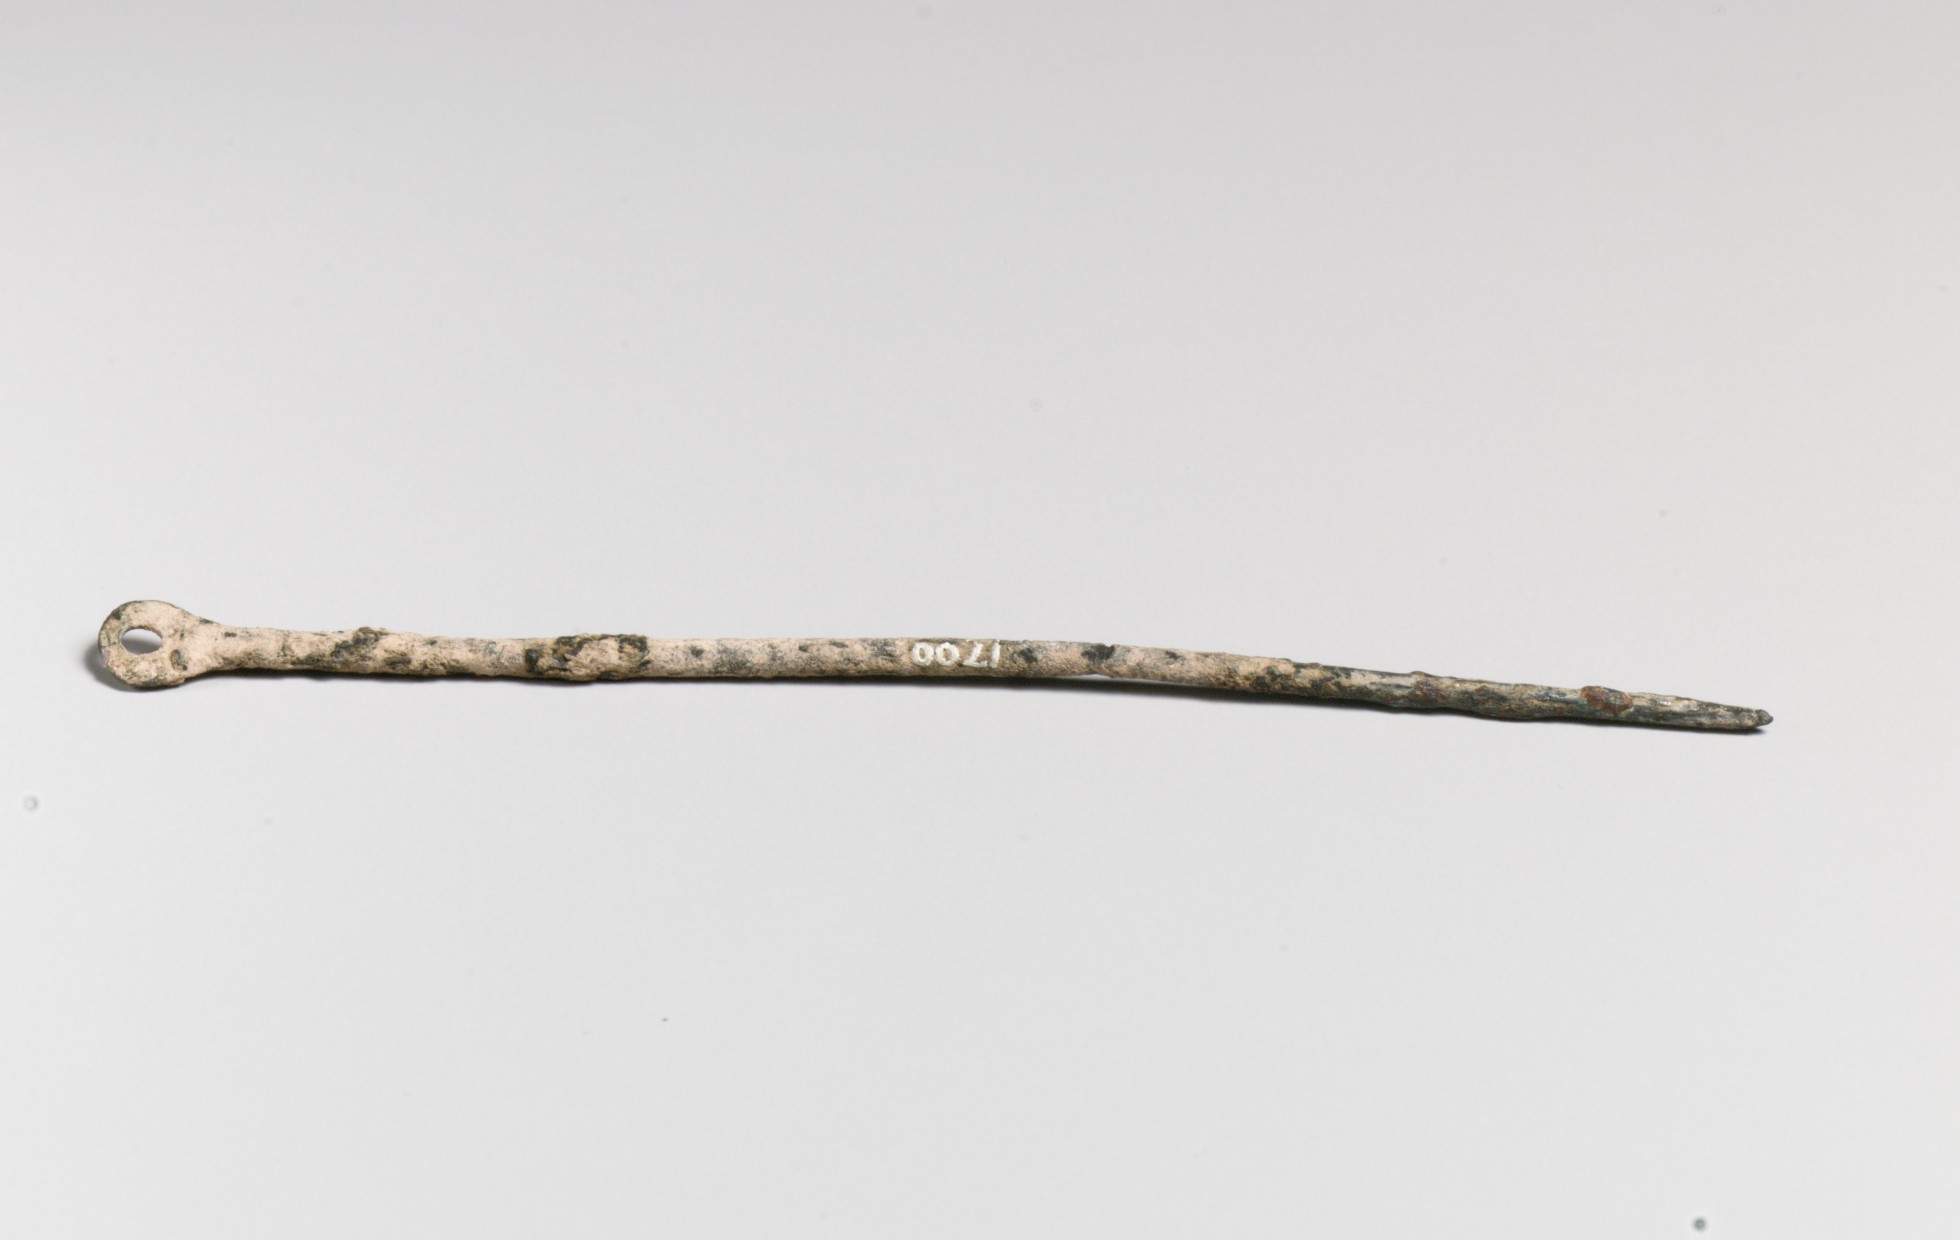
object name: skewer needle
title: Bronze needle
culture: minoan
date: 2400-1450 BCE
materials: bronze